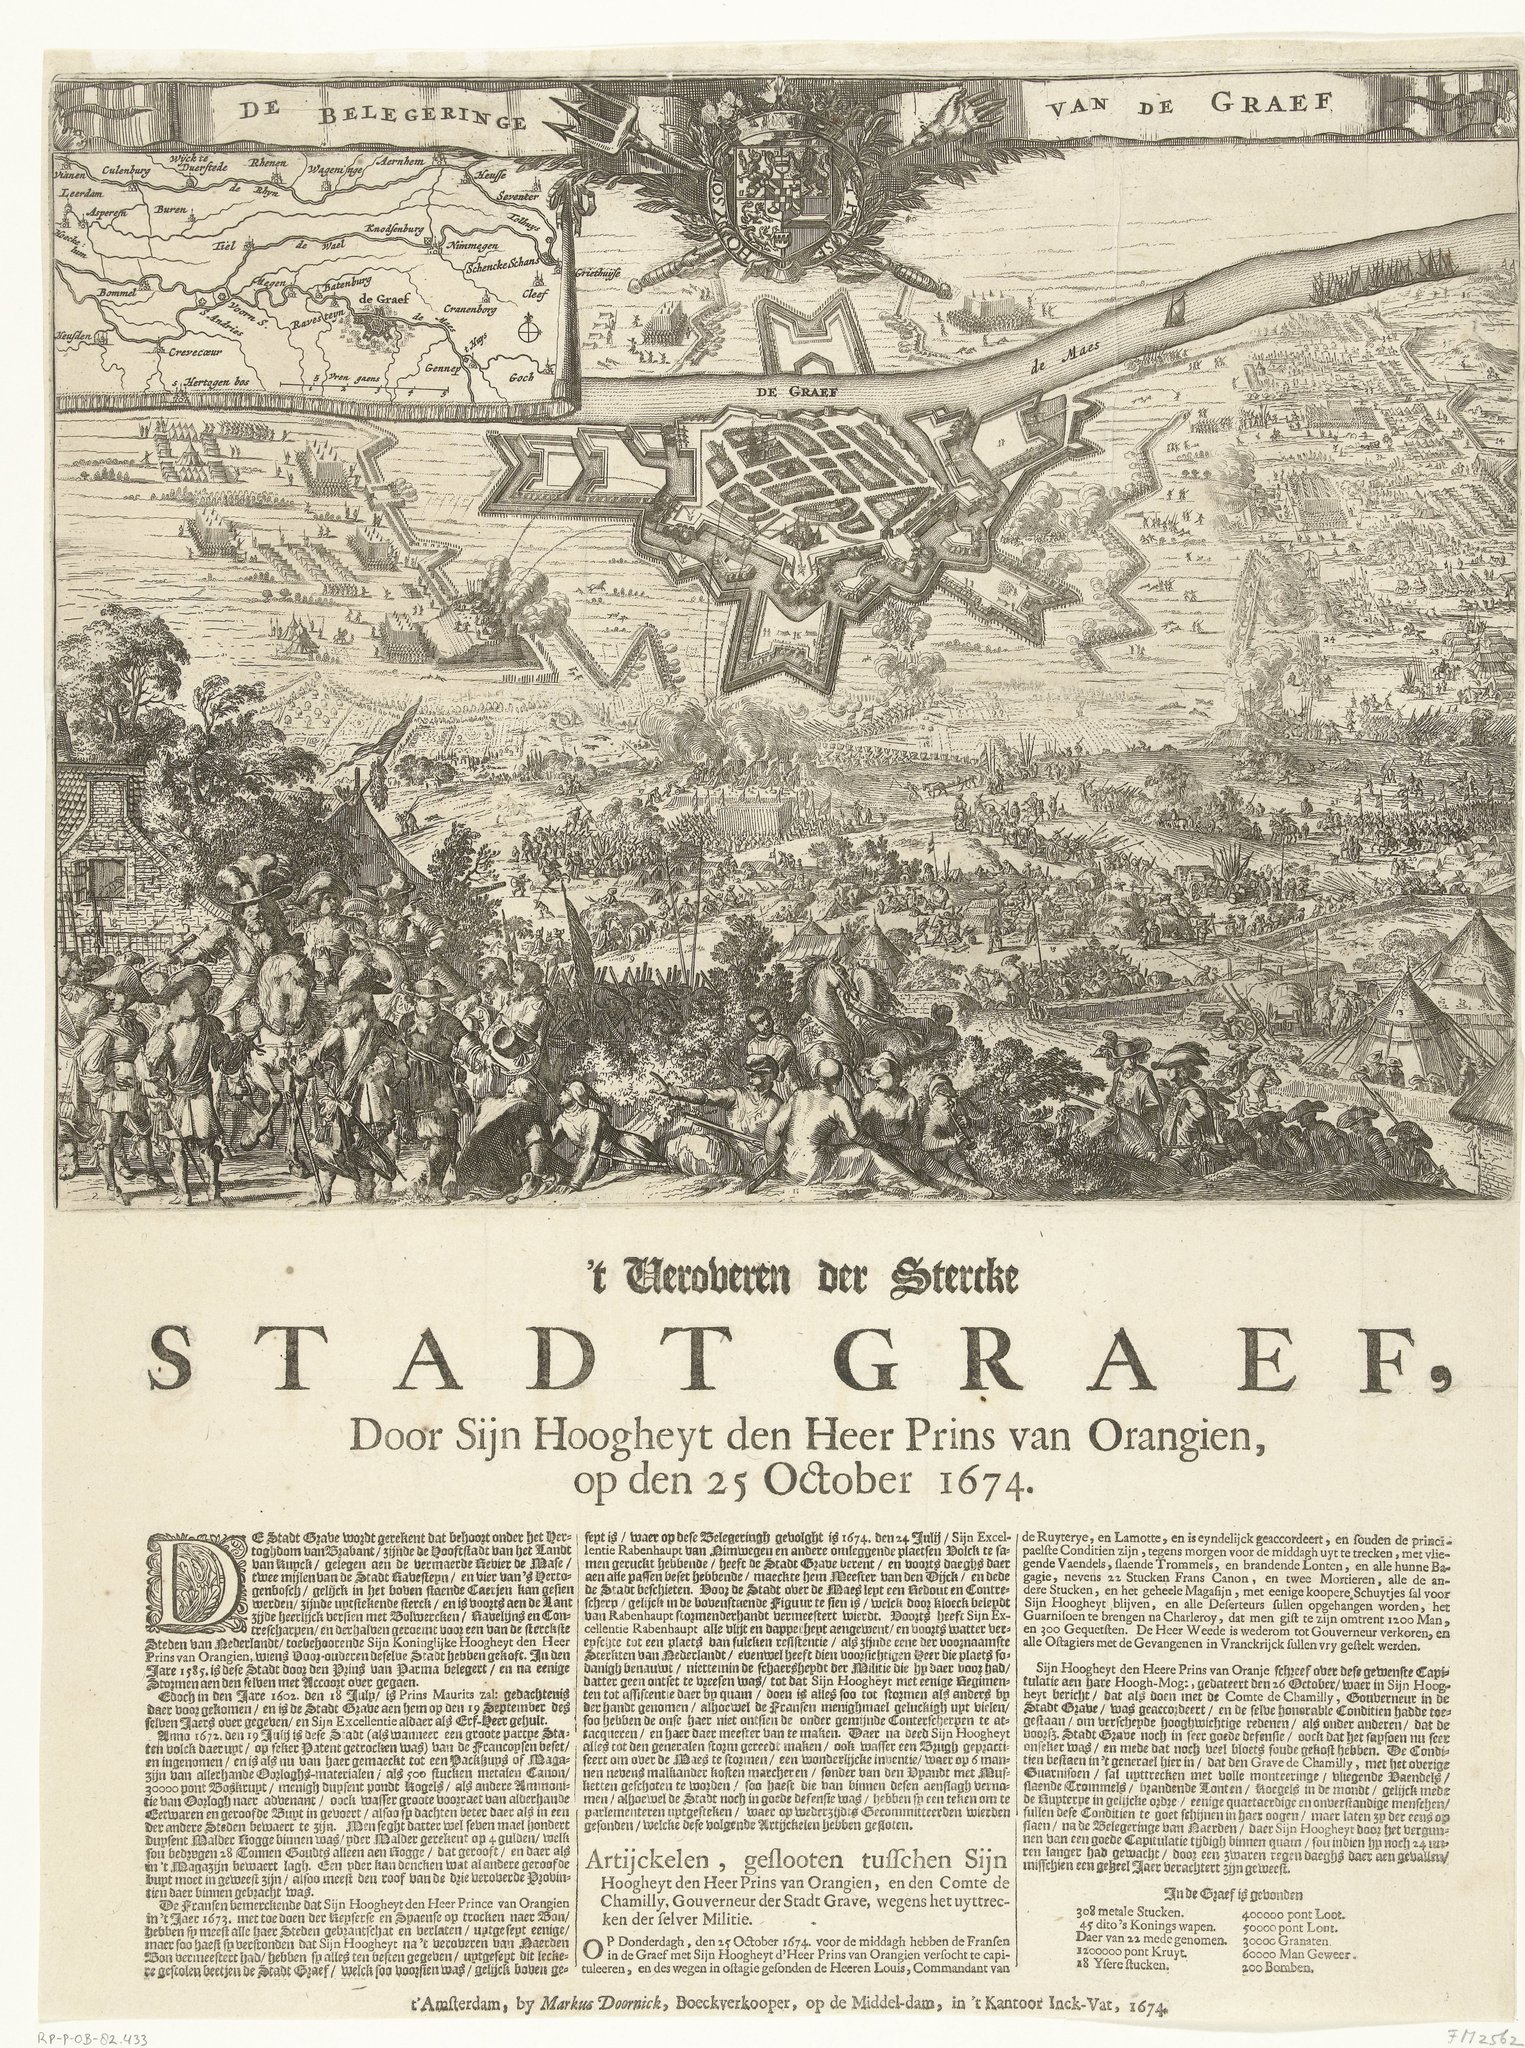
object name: print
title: Verovering van Grave door Willem III, 1674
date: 1673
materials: paper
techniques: etching, letterpress printing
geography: amsterdam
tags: the hague, william iii (prince of orange and king of england, scotland, and ireland), siege, position war, capture of city (after the siege), grave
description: Het beleg en de verovering van Grave door Willem III, 25 juli tot 29 oktober 1674. Gezicht op de belegering van de stad in vogelvluchtperspectief. Op de voorgrond de prins met zijn staf. Bovenaan het wapen van de prins. Midden op de voorgrond een groepje buitenanders waaronder enkele zwarten. Op het blad onder de plaat een tekst in 3 kolommen met de artikelen van overgave. De cijfers en de naam van Romeyn de Hooghe weggepolijst.